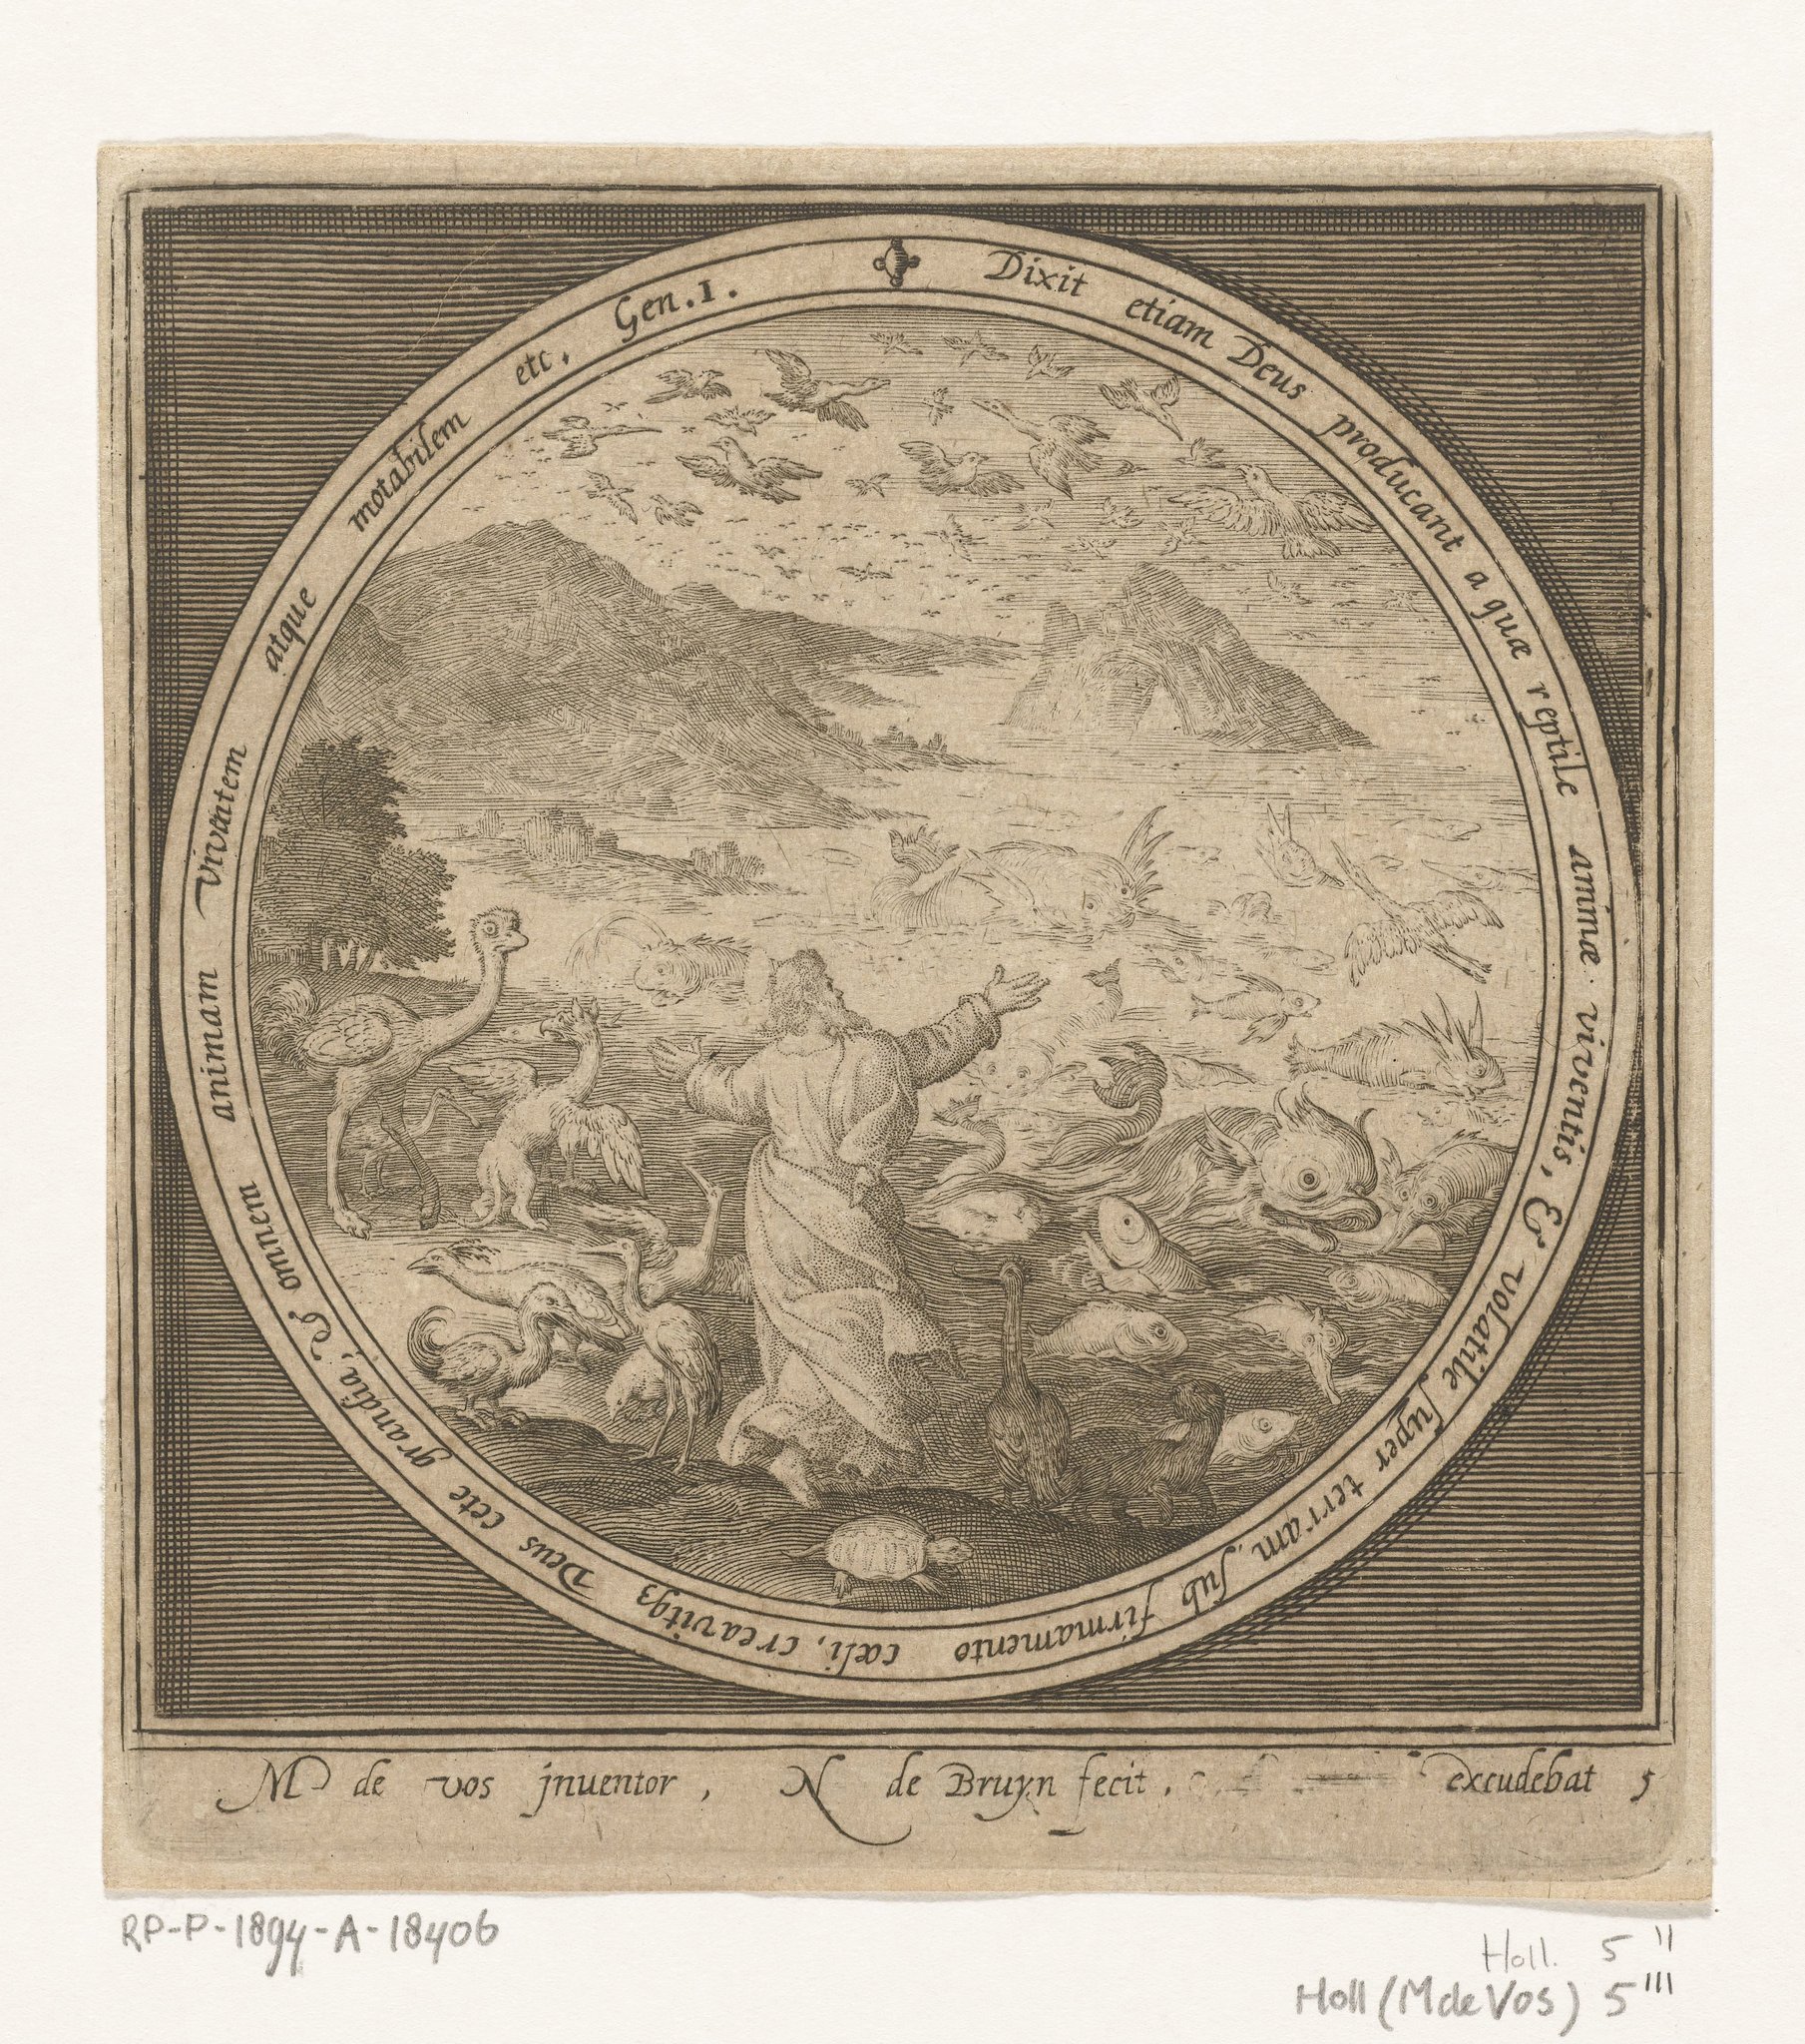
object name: print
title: Van schepping tot verdrijving uit paradijs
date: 1581-1656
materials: paper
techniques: engraving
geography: netherlands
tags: creation of birds and fishes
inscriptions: collector's mark: Lugt 2510, collector's mark: Lugt 1606, collector's mark: 2228, collector's mark: Lugt 2482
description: Vijfde dag van schepping: God schept vissen en vogels zodat het water wemelt van de levende wezens en langs het hemelgewelf vogels vliegen. In medaillon met als opschrift een bijbeltekst in Latijn uit Genesis 1, binnen rechthoekige omlijsting.